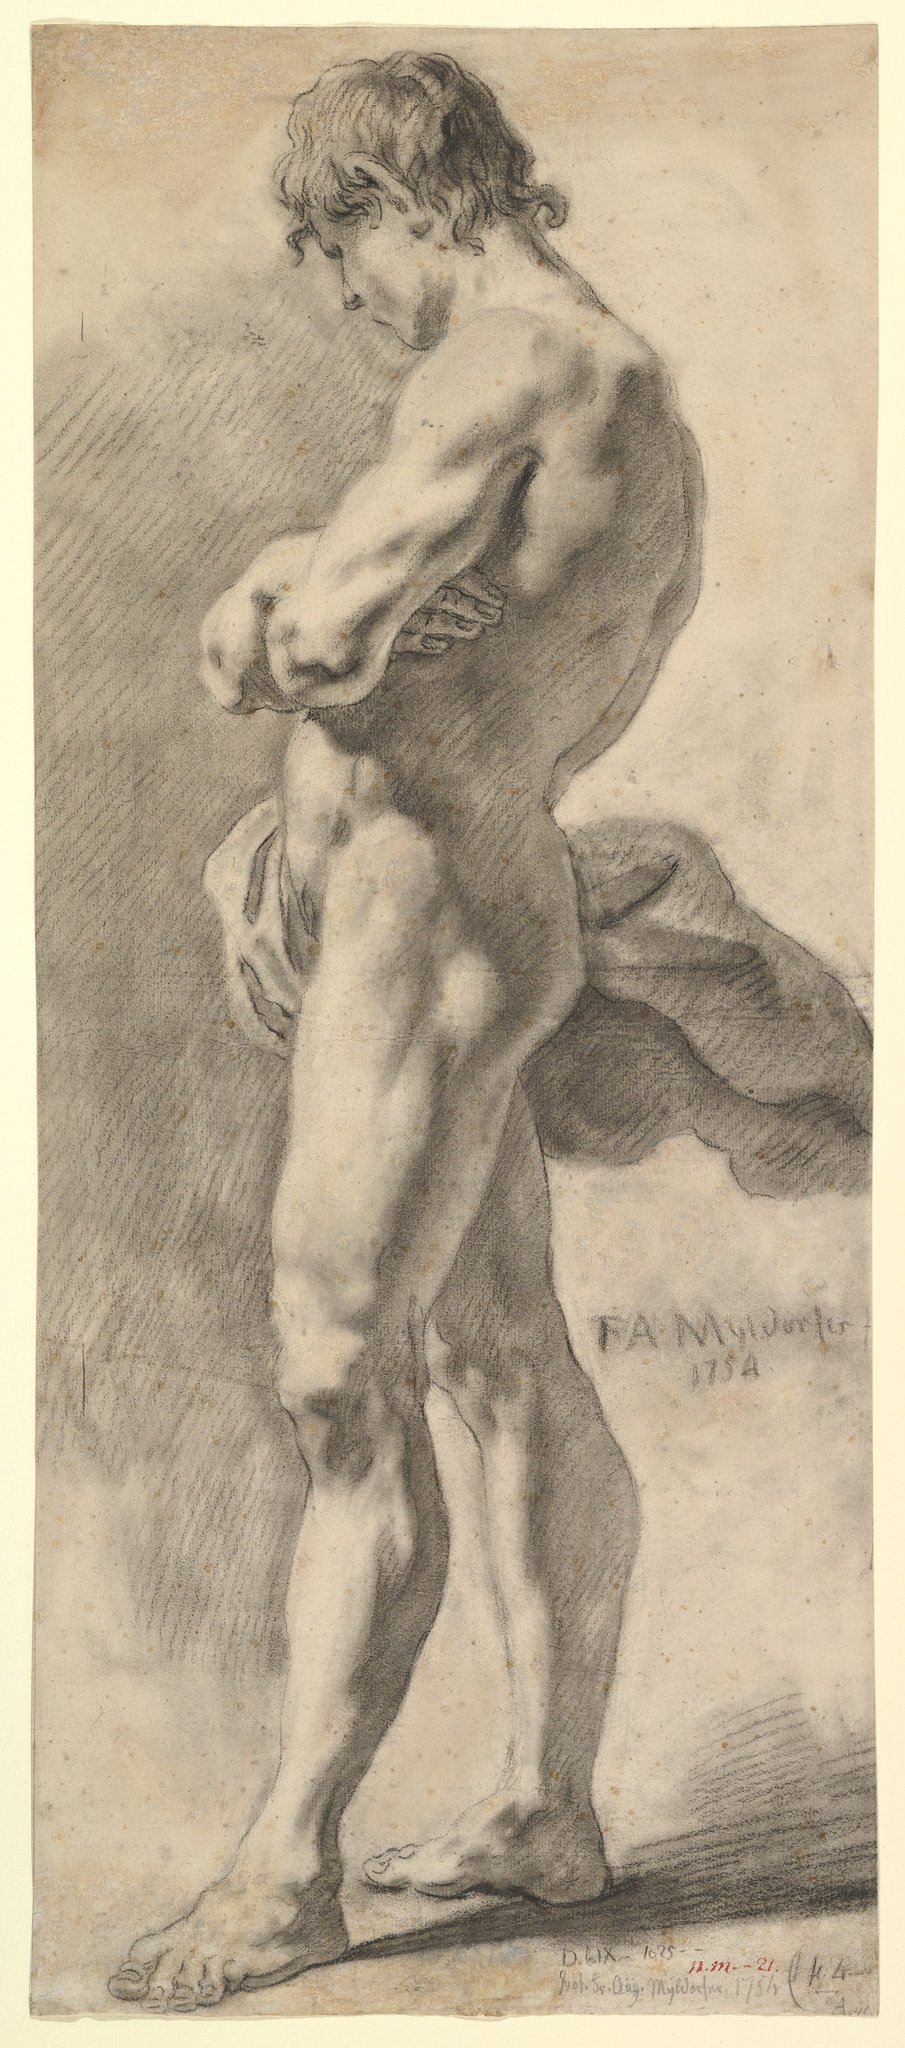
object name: drawing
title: Standing Male Nude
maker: franz august myldorfer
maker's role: artist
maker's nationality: austrian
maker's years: 1750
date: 1754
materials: chalk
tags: male nudes